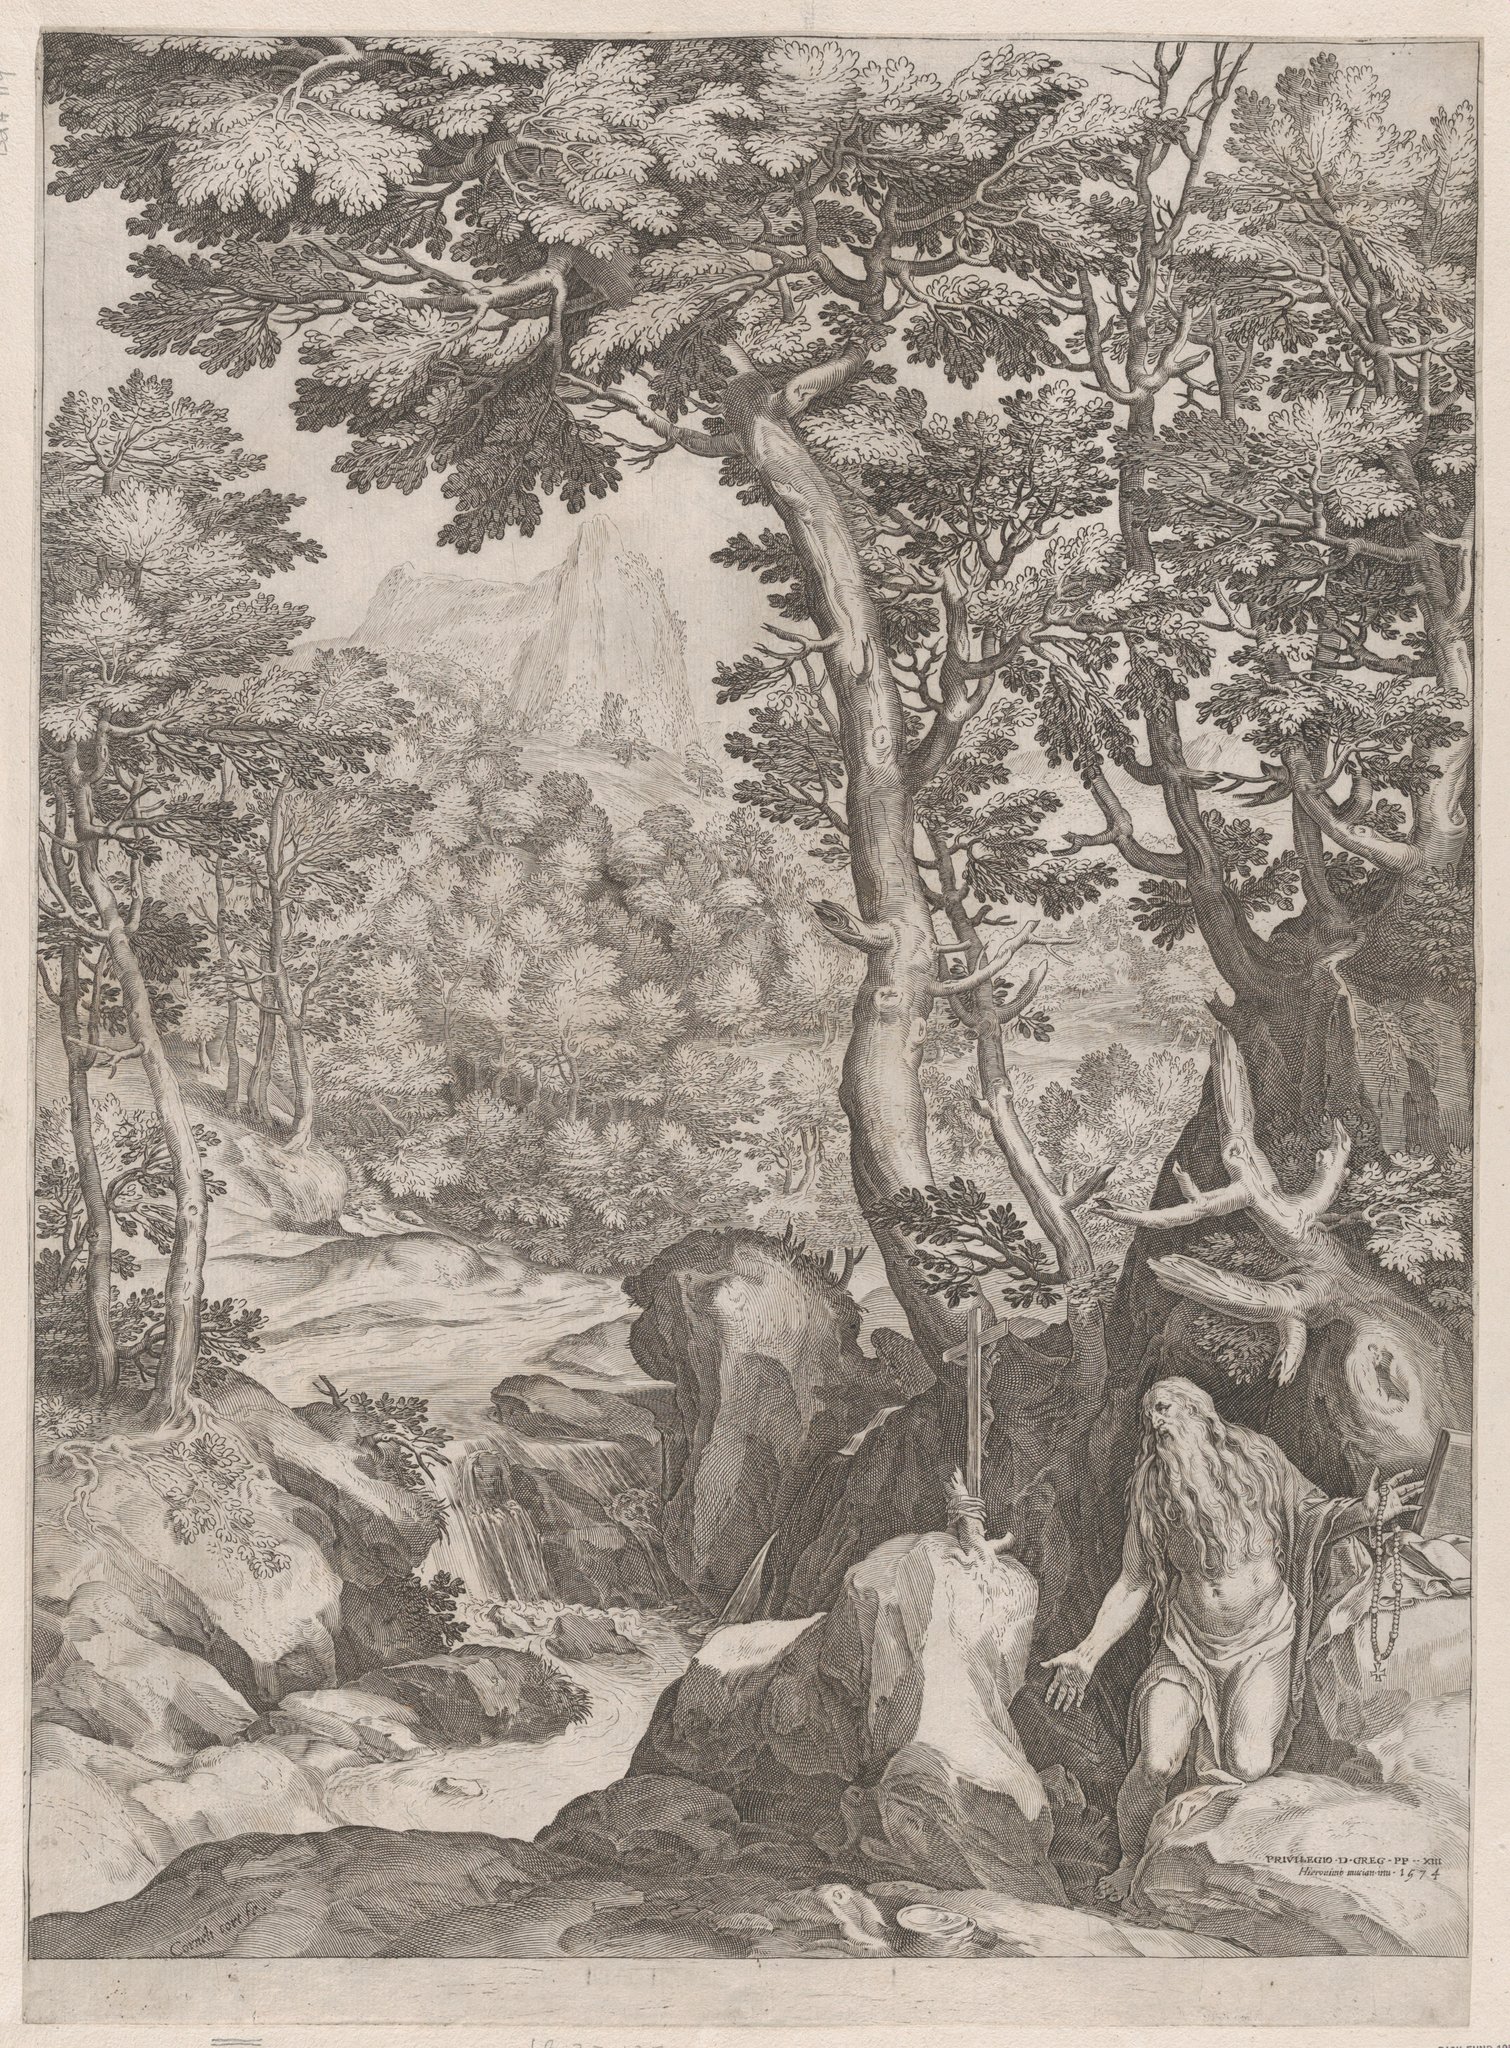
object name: print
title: St Onuphrius in the Wilderness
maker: cornelis cort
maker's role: artist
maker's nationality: netherlandish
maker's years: 1533-1578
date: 1574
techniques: engraving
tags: forests,cross,saints